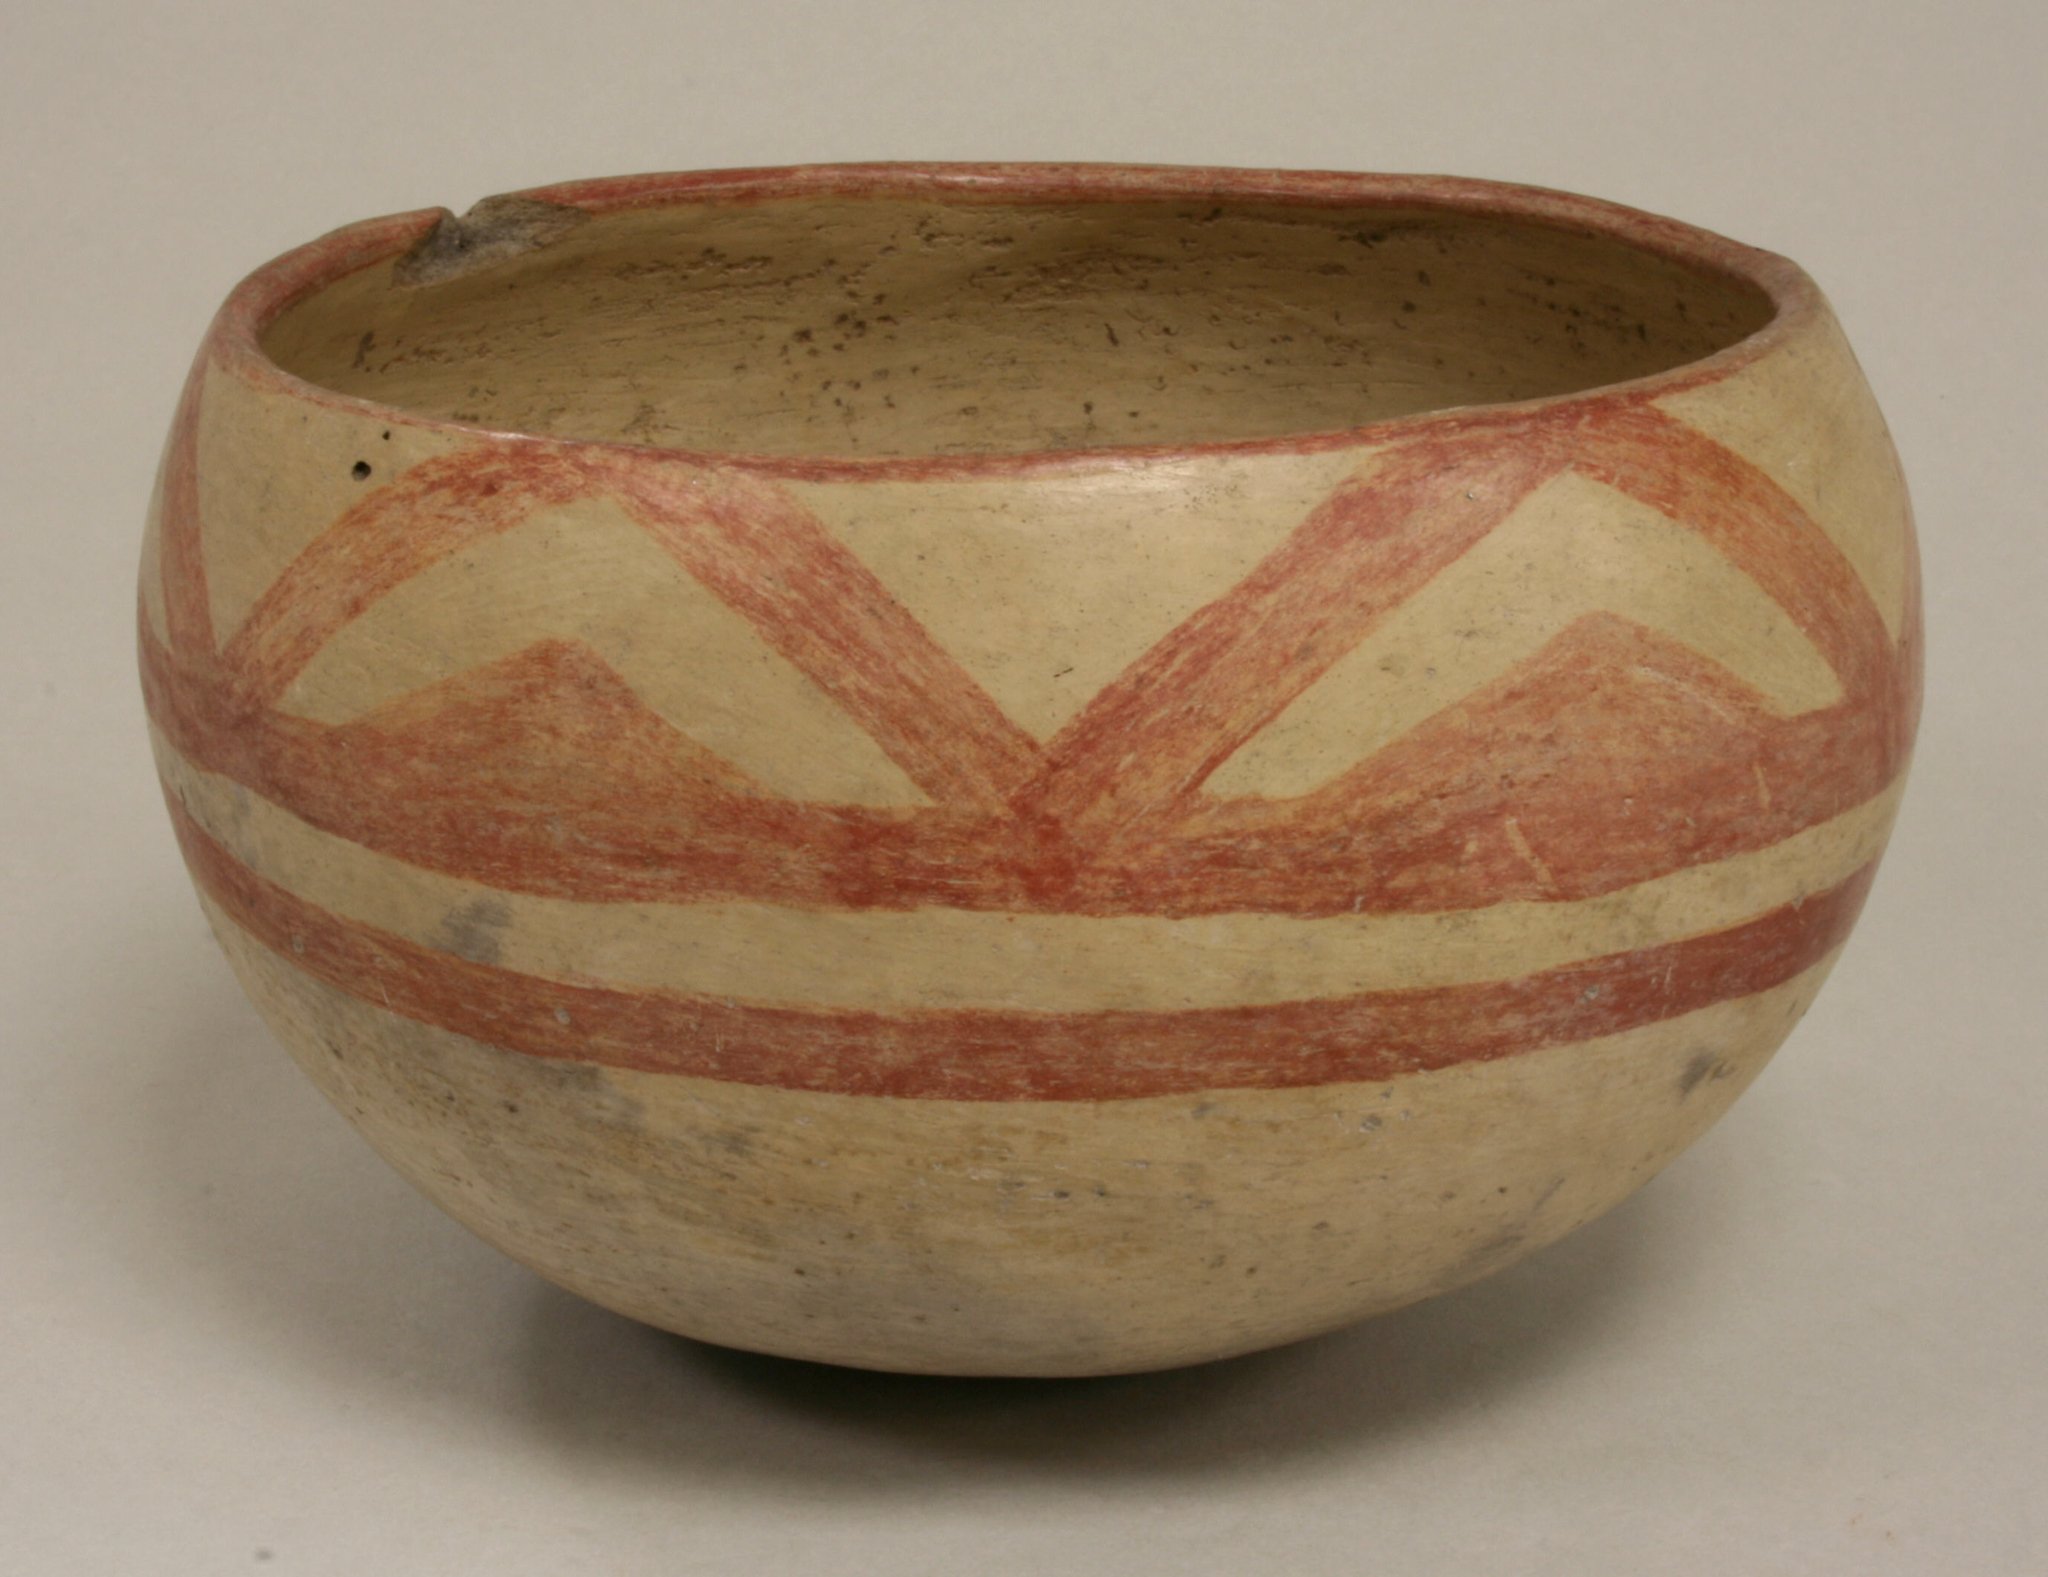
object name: bowl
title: Bowl with Geometric Design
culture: mexican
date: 901-1500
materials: ceramic, pigment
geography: mexico